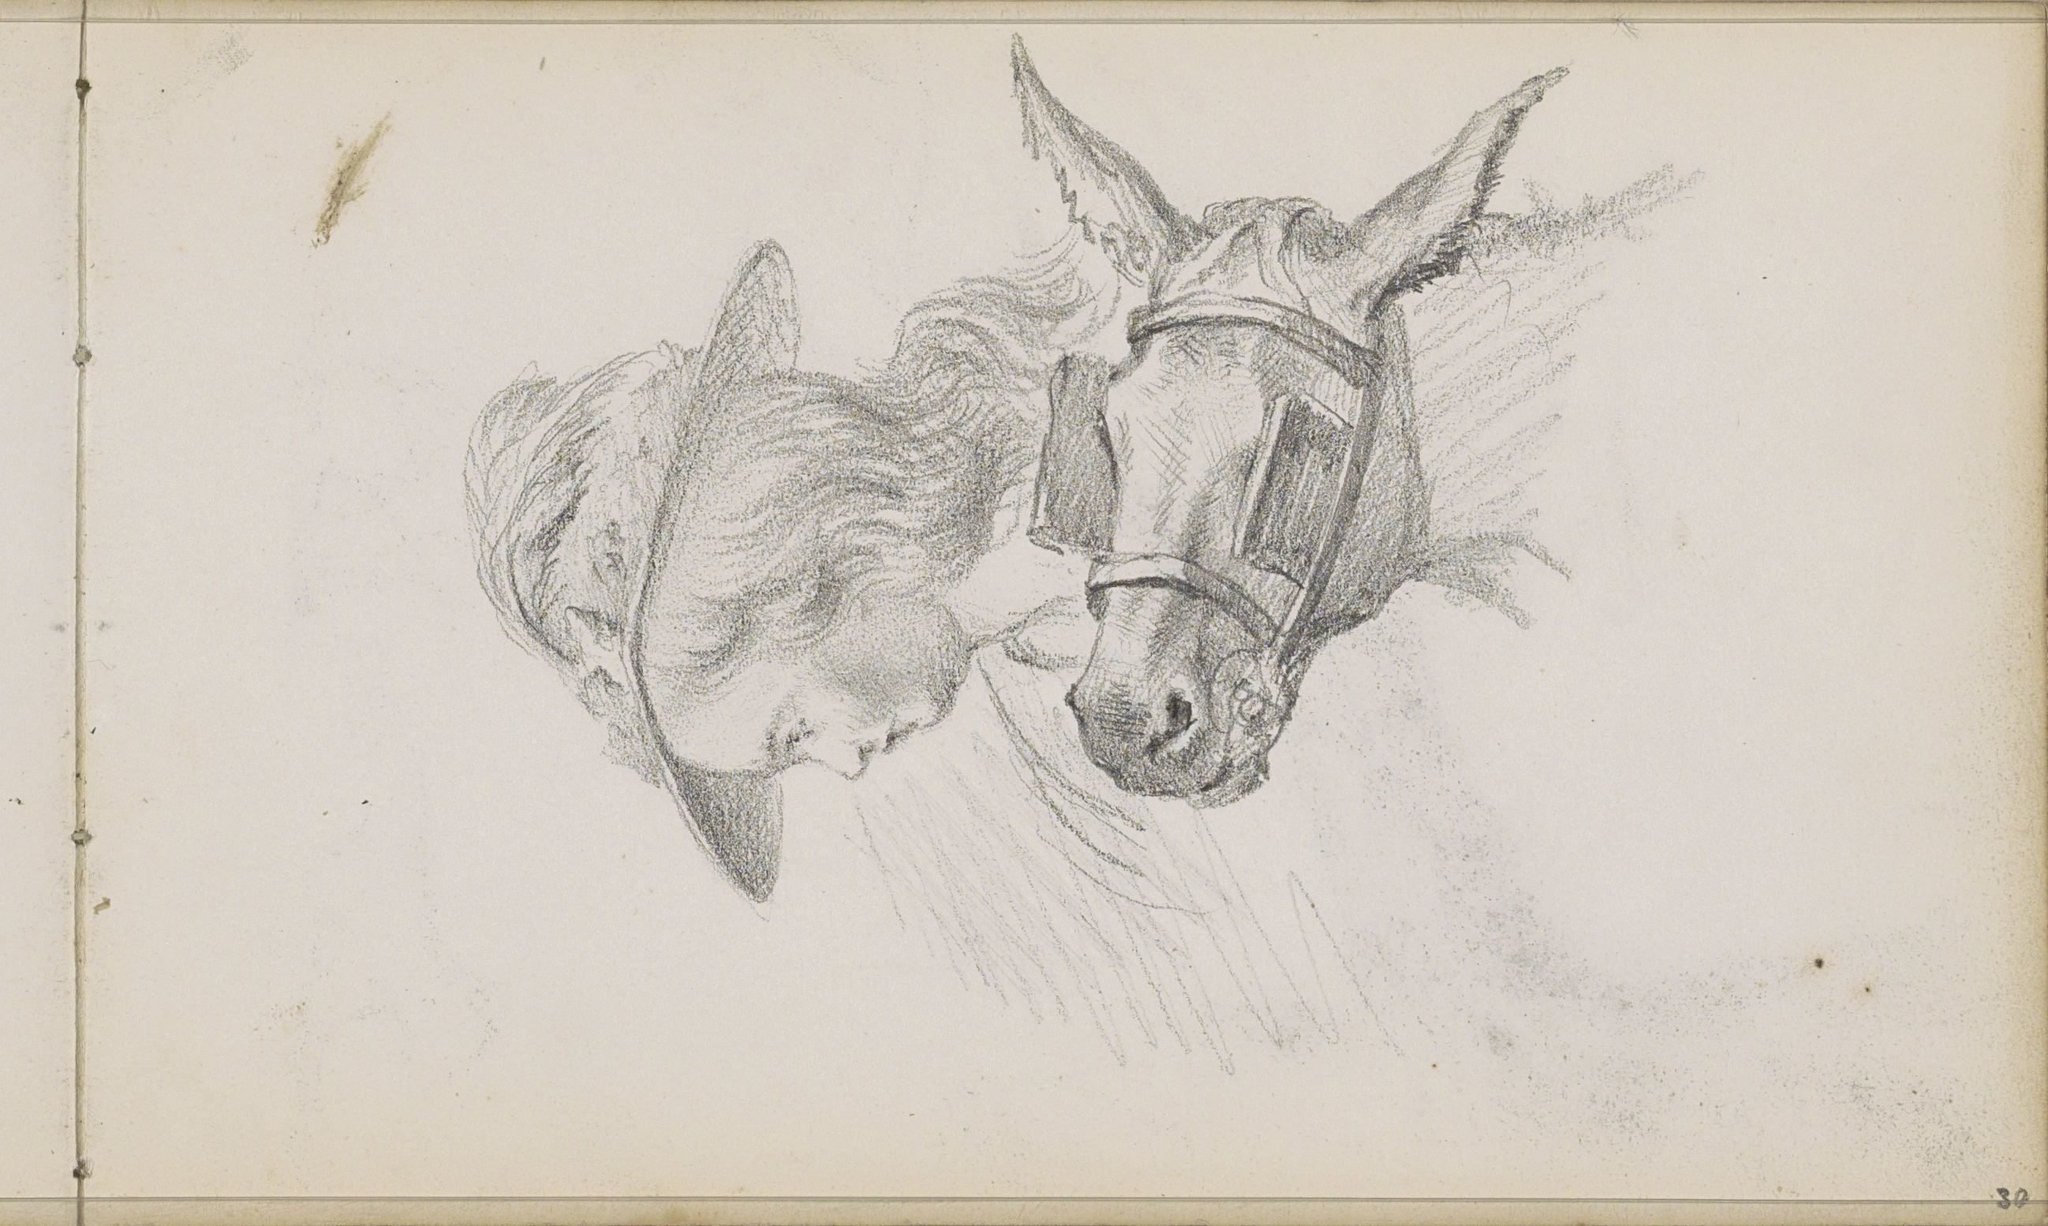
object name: sketchbook leaf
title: Meisje met een rieten hoed en een kop van een ezel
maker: willem cornelis rip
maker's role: draughtsman, painter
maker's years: 1856-1922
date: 1874-1875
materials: paper, pencil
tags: head-gear: hat (+ women's clothes), girl (child between toddler and youth), mule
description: Blad 30 recto uit een schetsboek met 46 bladen.